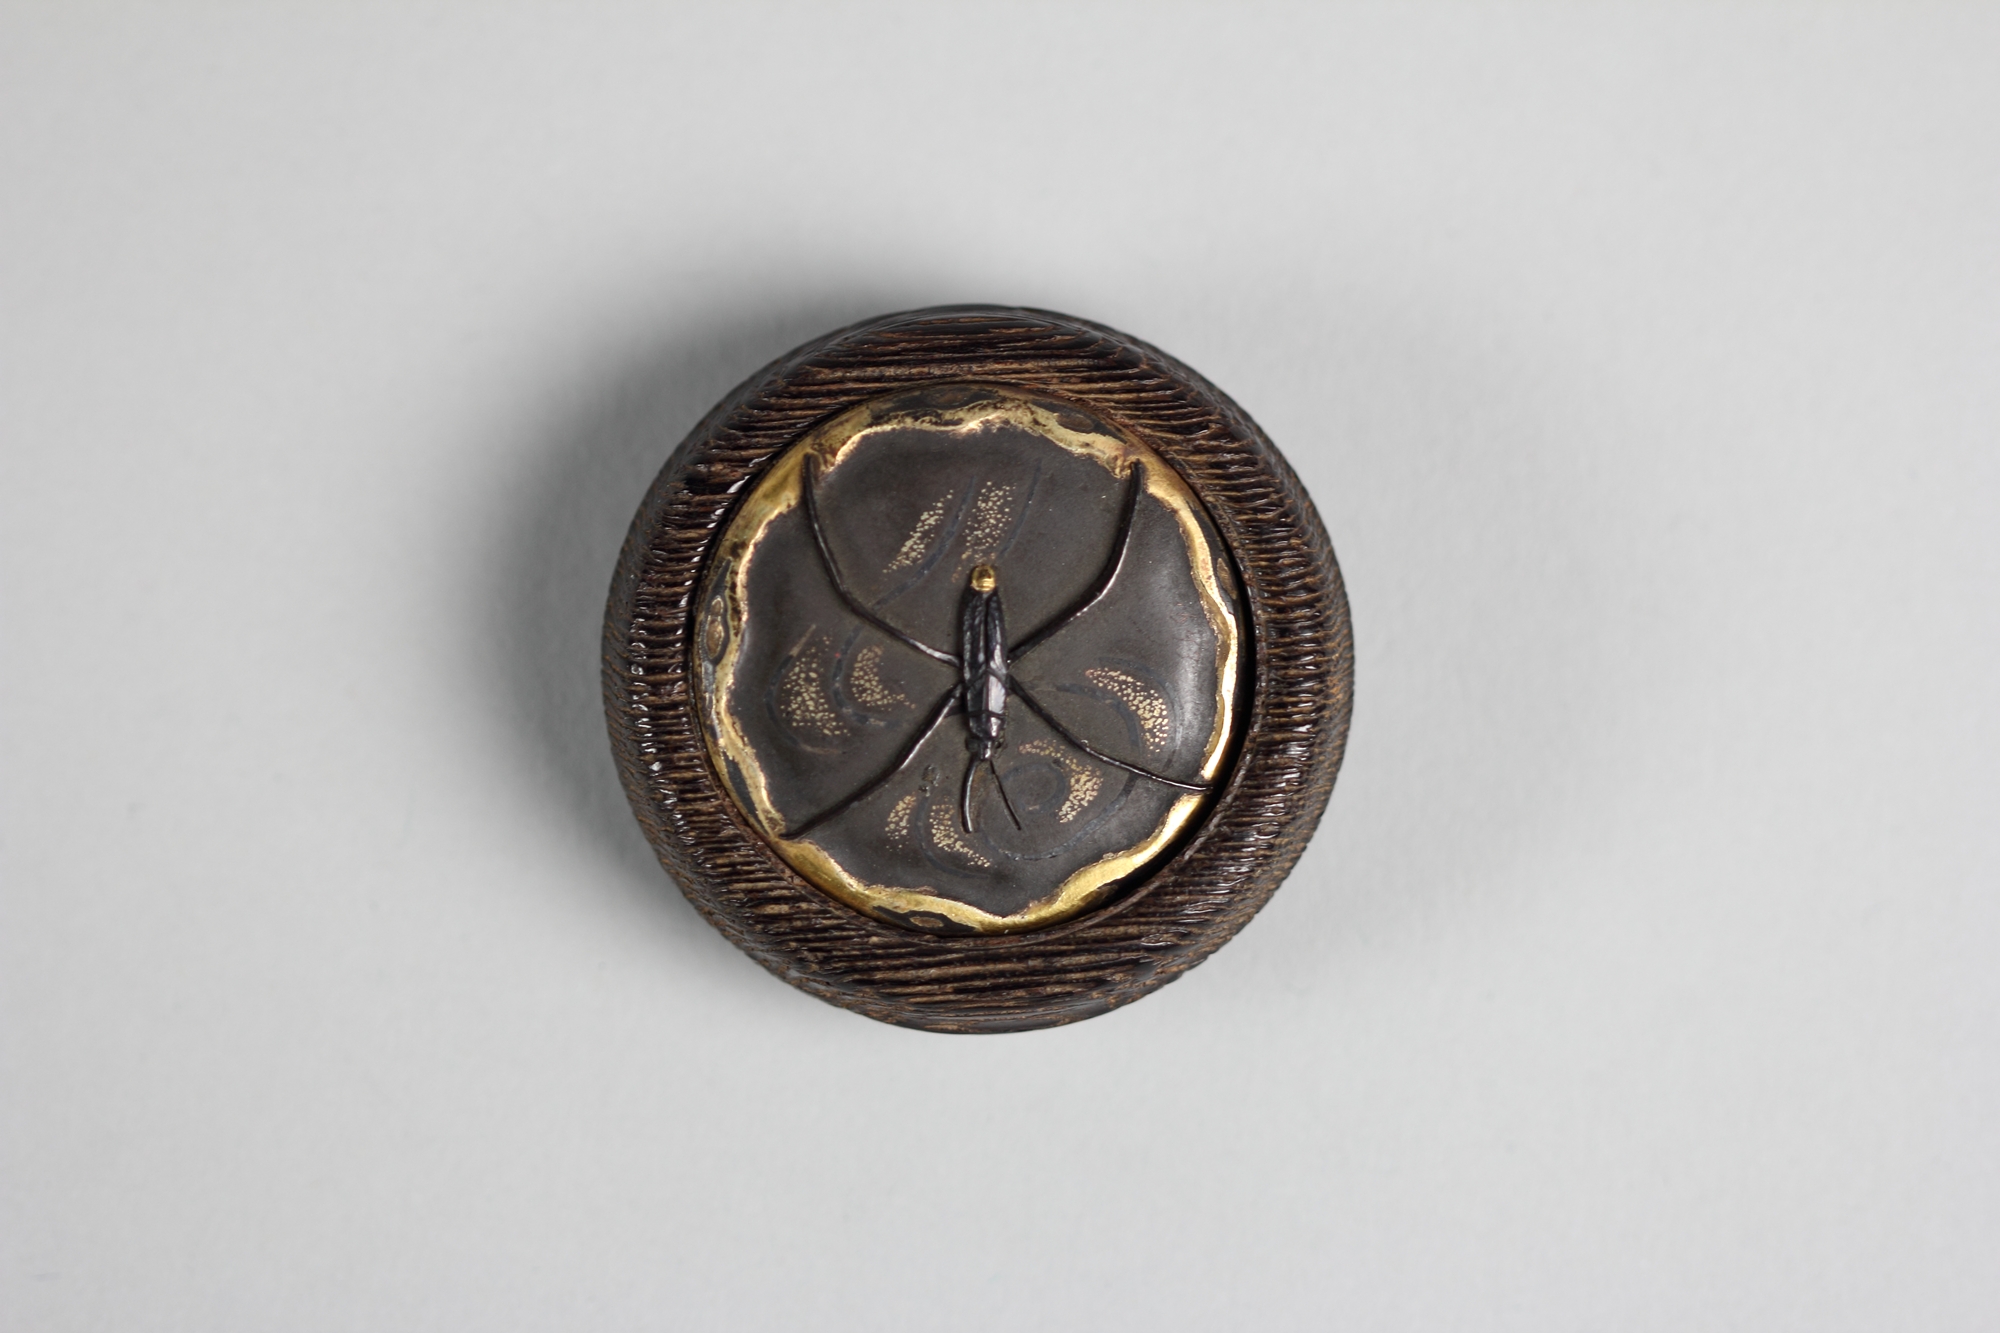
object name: netsuke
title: Netsuke with Decoration of Insect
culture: japanese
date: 1801-1900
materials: metal, wood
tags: insects